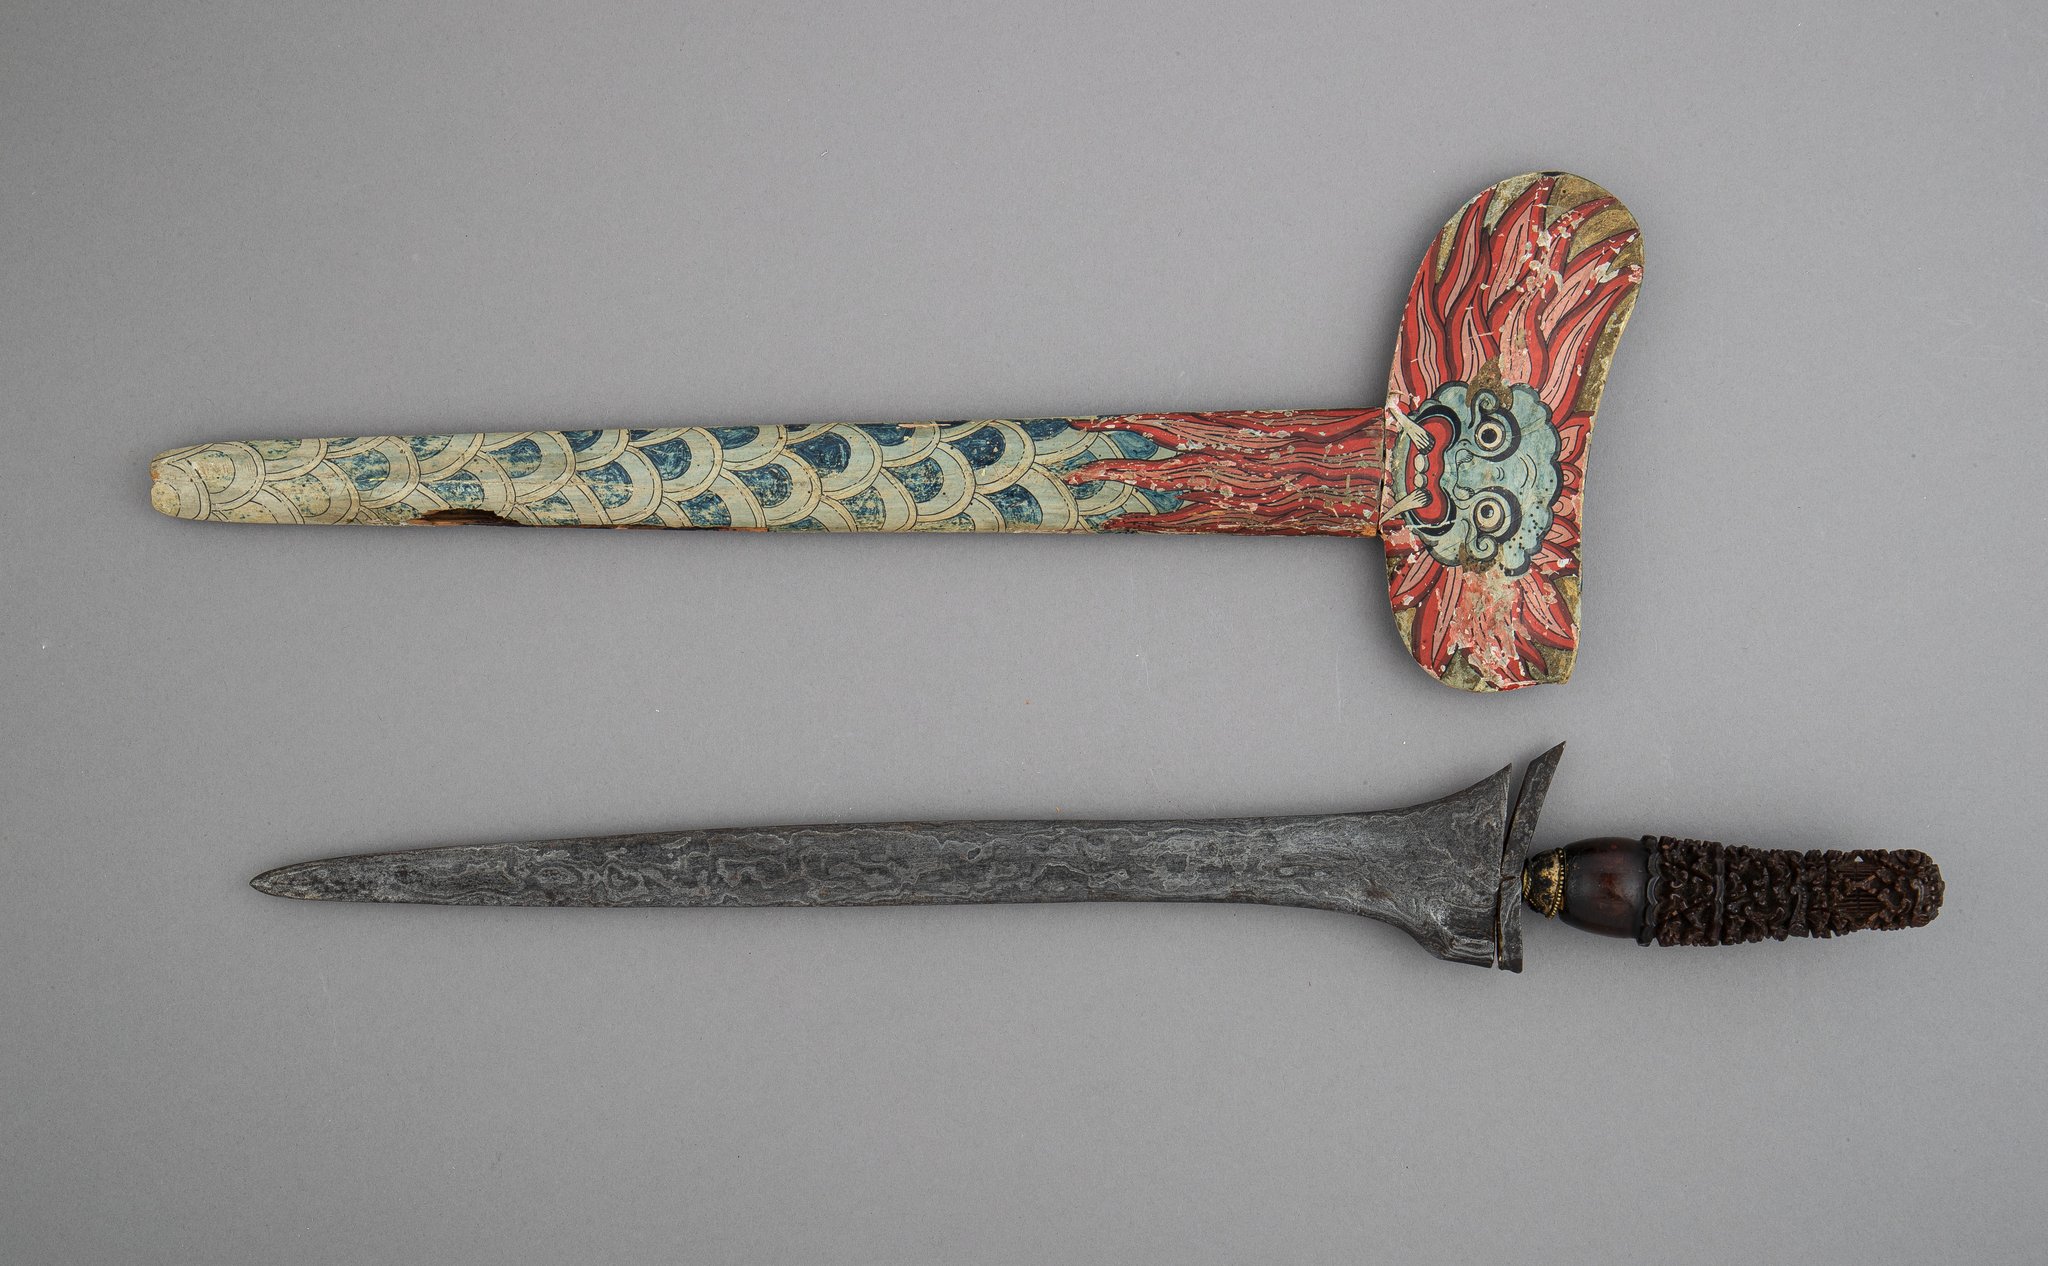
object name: kris with sheath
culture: javanese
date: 1501-1900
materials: gold, steel, wood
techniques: polychromy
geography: indonesia